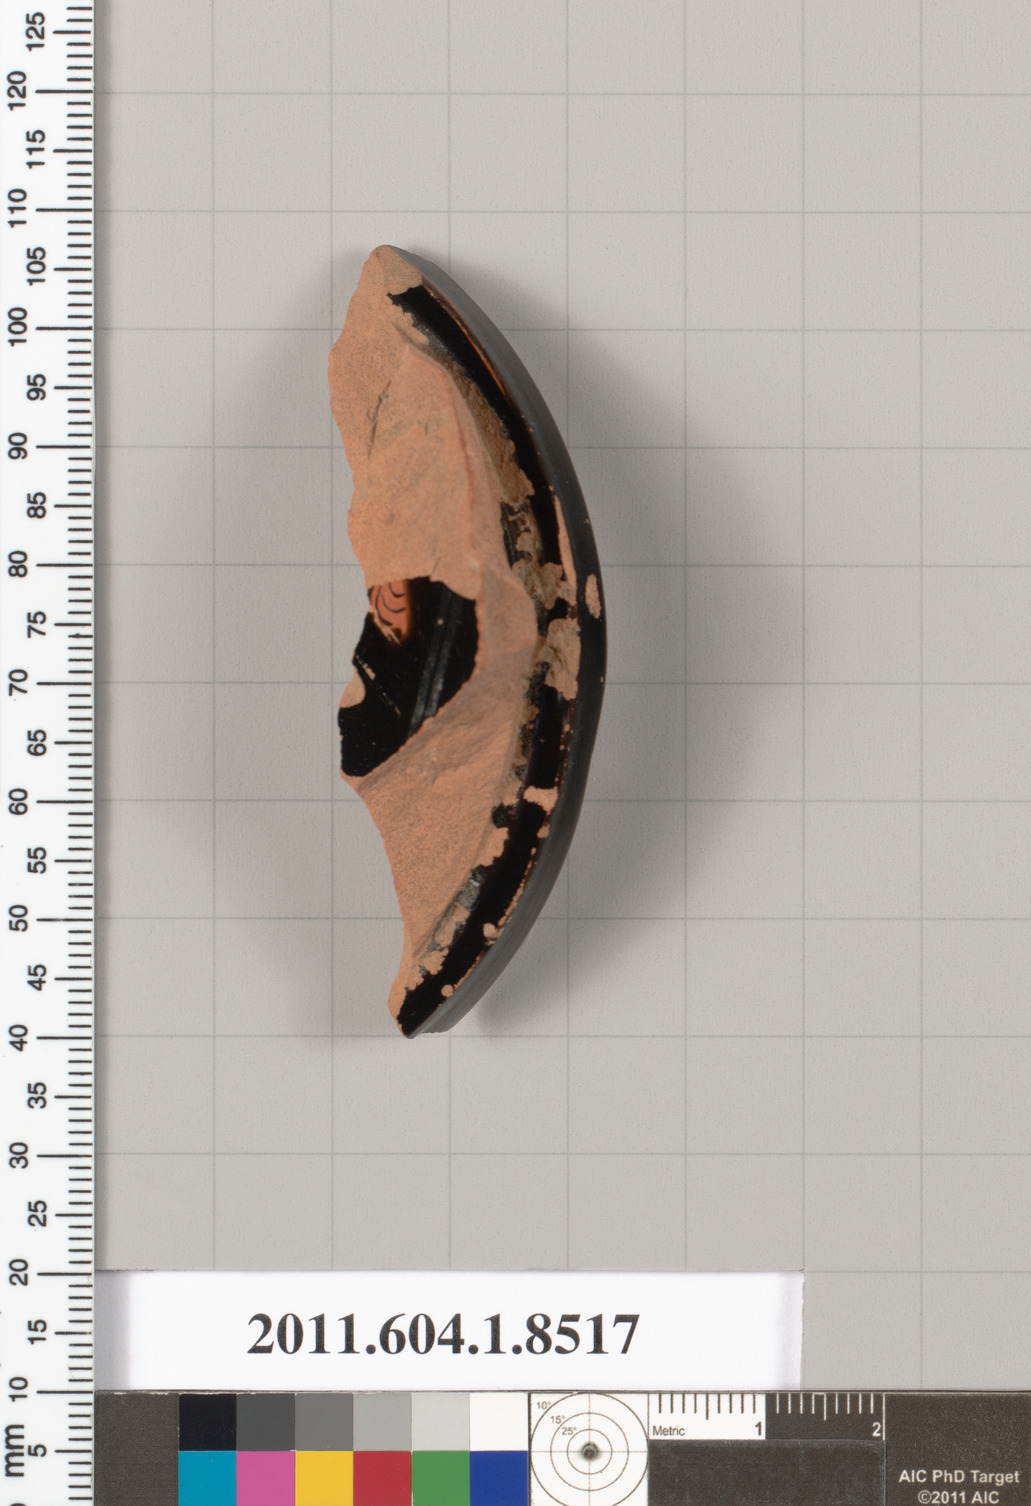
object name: kylix fragment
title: Terracotta fragment of a stemless kylix (drinking cup)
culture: greek, attic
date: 460-450 BCE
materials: terracotta